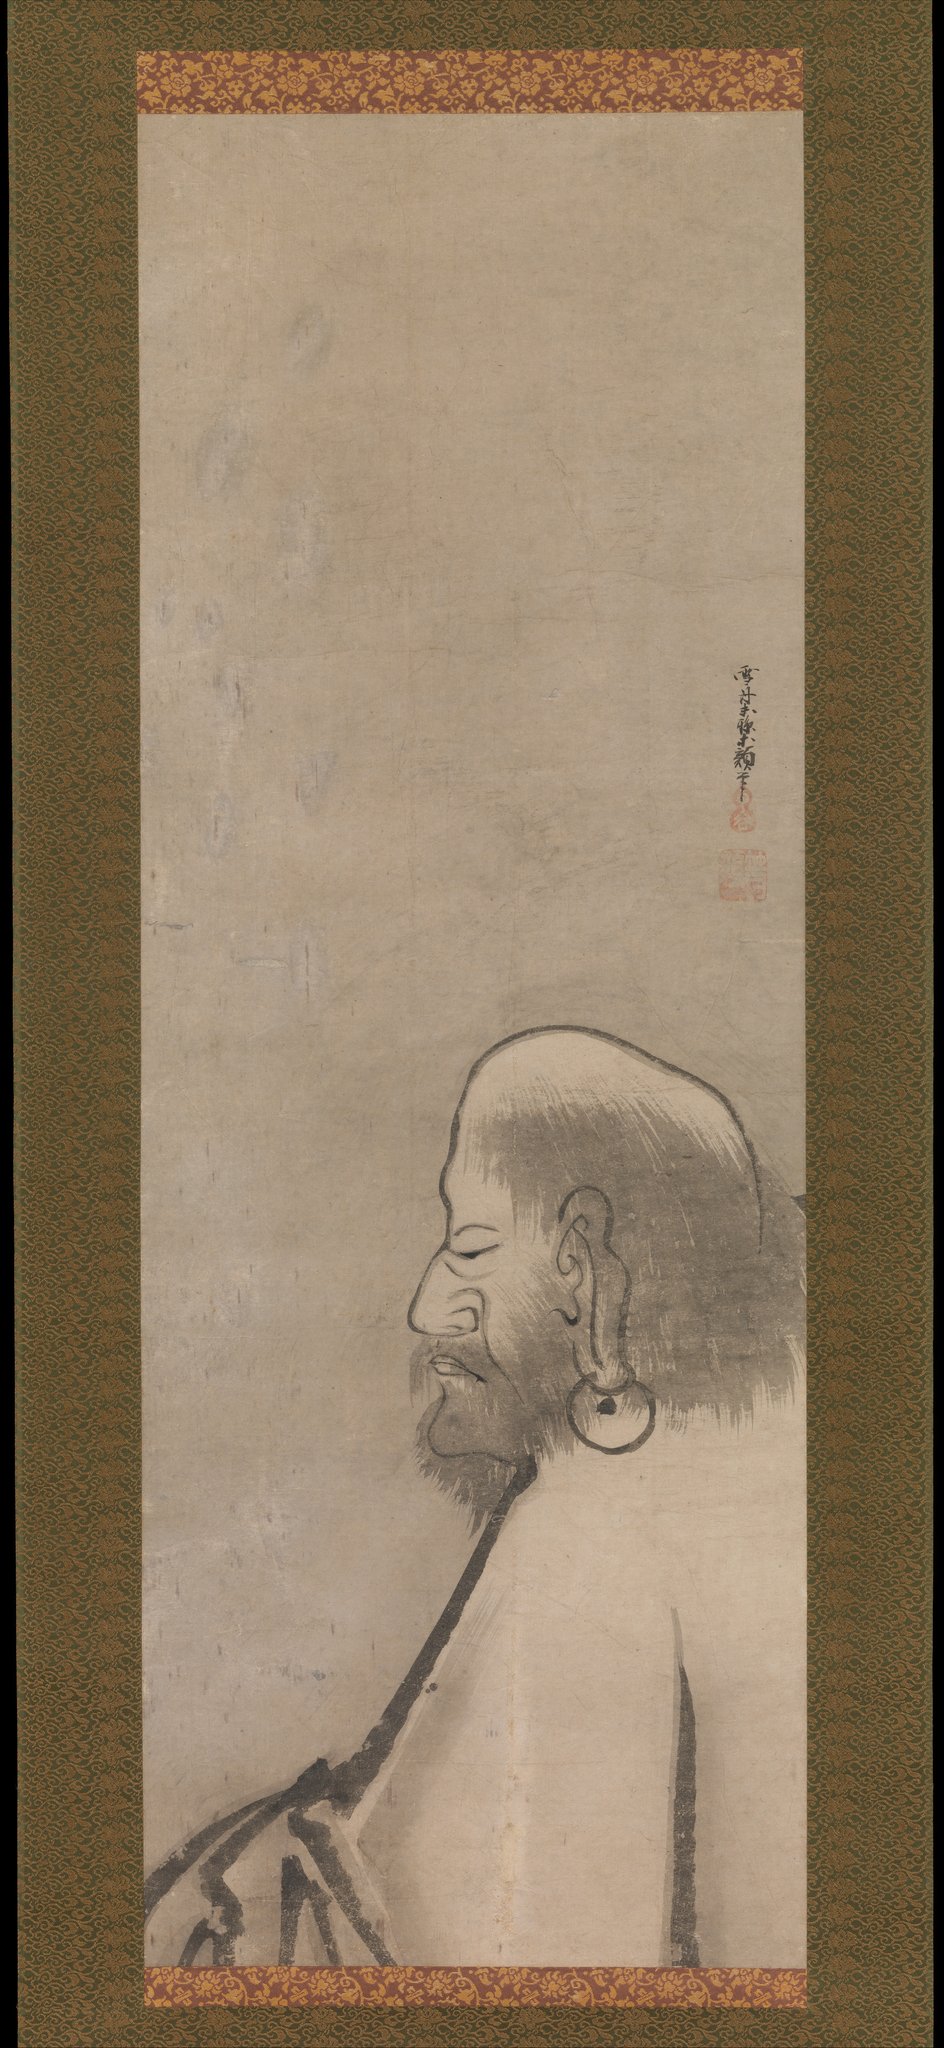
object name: hanging scroll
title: Portrait of Daruma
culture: japanese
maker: unkoku tōgan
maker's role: artist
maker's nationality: japanese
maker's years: 1547-1618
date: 1601-1633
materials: ink, paper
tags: men,portraits,profiles,buddhism